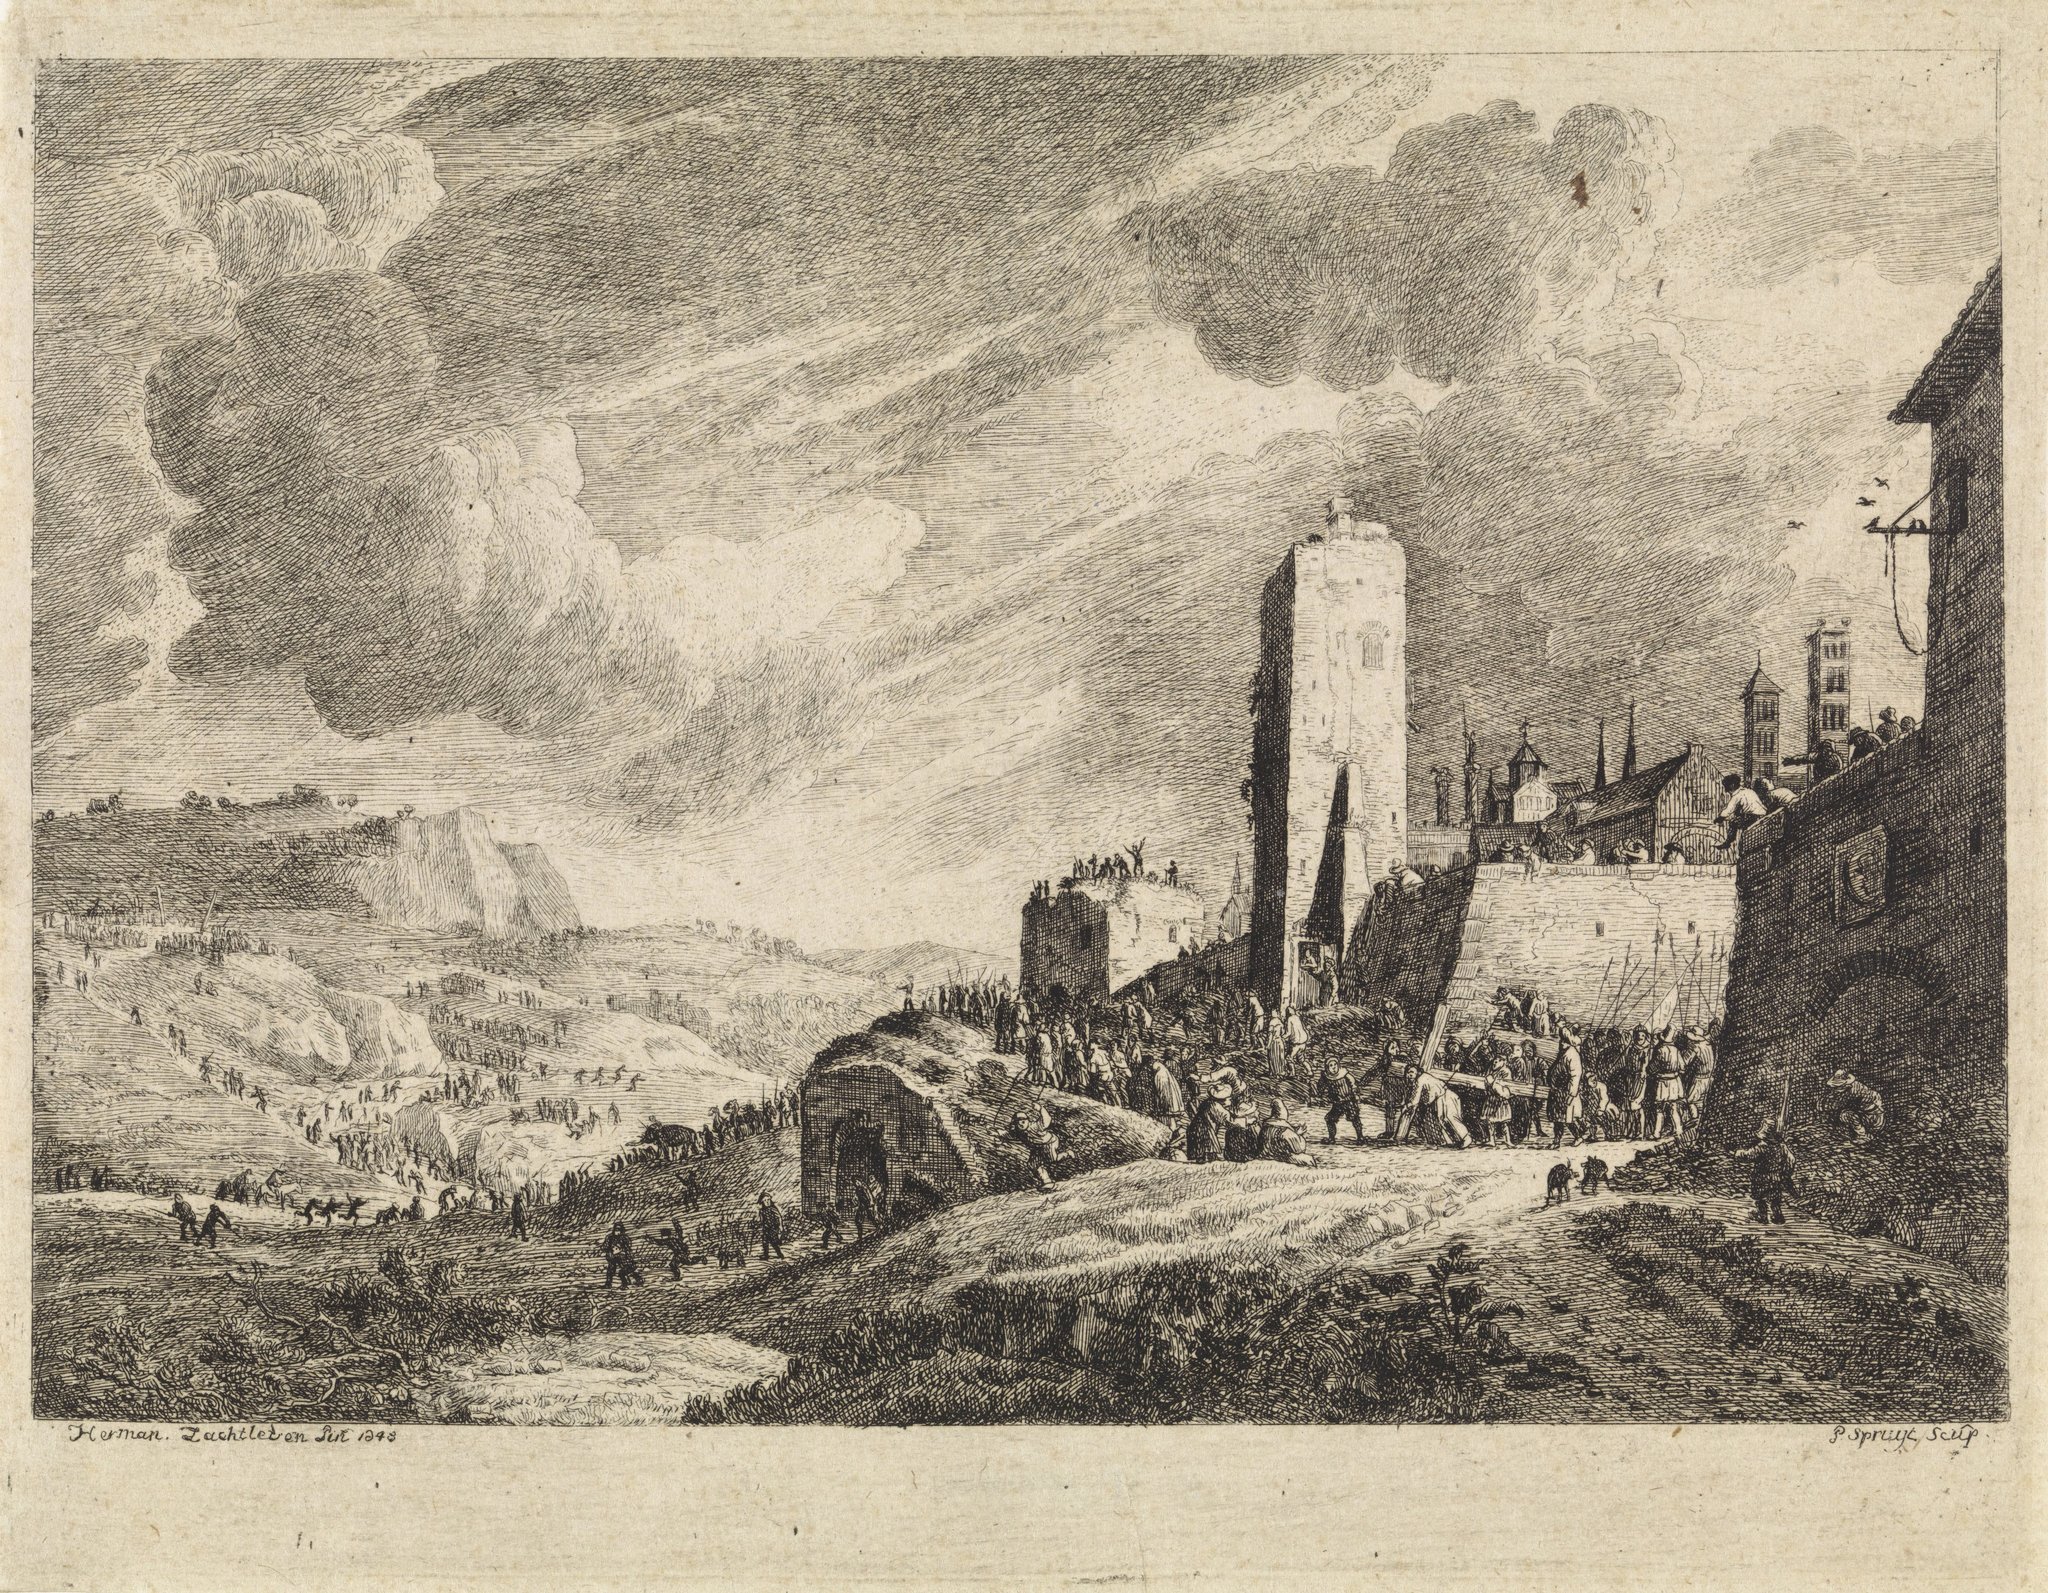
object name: print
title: Kruisdraging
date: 1747-1801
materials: paper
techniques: etching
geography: ghent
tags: carrying of the cross: christ bearing the cross, alone or with the help of others (e.g. simon the cyrenian)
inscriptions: collector's mark: Lugt 2228, collector's mark: Lugt 1697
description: Landschap met Christus, die het kruis draagt. De stoet trekt vanuit Jeruzalem richting Golgota.